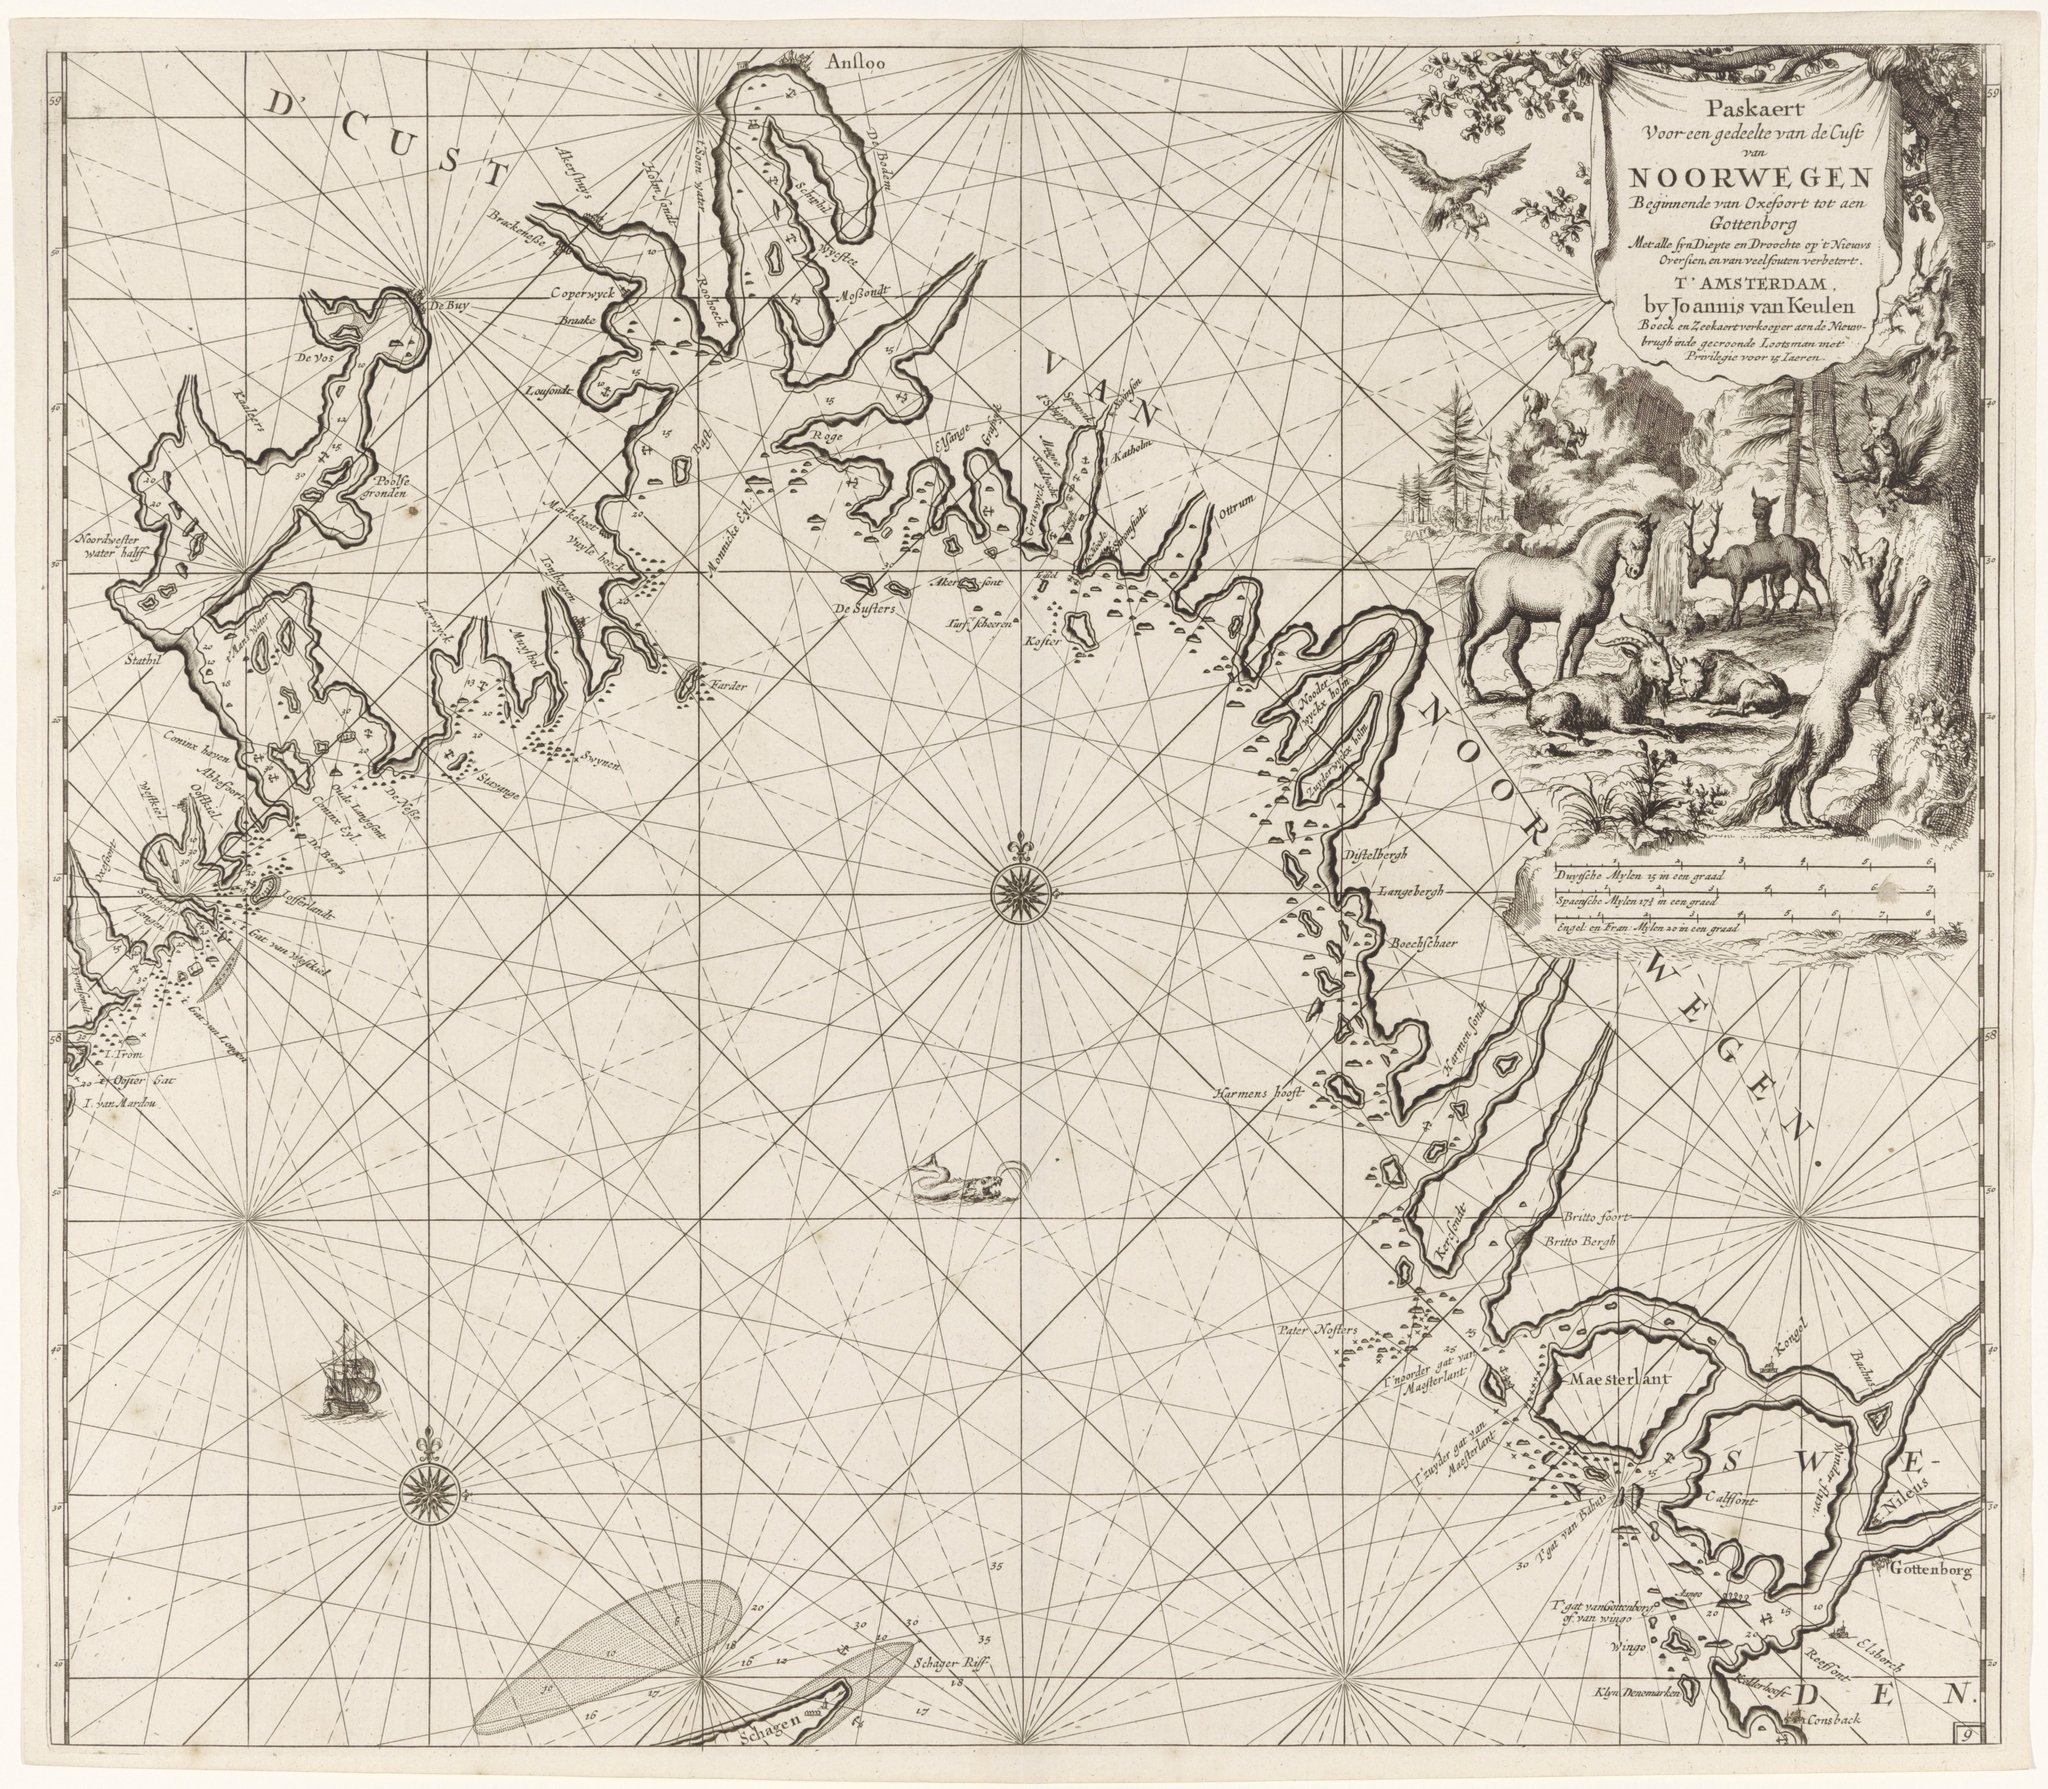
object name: print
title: Paskaart van de kust van Noorwegen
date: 1681-1799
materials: paper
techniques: engraving, etching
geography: amsterdam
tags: waterfall, forest, wood, horse, rodents: squirrel, beasts of prey, predatory animals: fox, norway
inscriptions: collector's mark: Lugt 2228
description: Paskaart van de kust van Noorwegen, vanaf Göteborg in Zweden tot aan Kamperhaug, met twee kompasrozen, het Noorden ligt boven. Rechtsboven een cartouche met de titel en het adres van de uitgever. Bij de cartouche een bergachtig landschap met hertjes, geiten, een paard en een vos die op twee eekhoorns jaagt. Onder het tafereel de schaal in Duitse, Spaanse en Engelse of Franse mijlen.